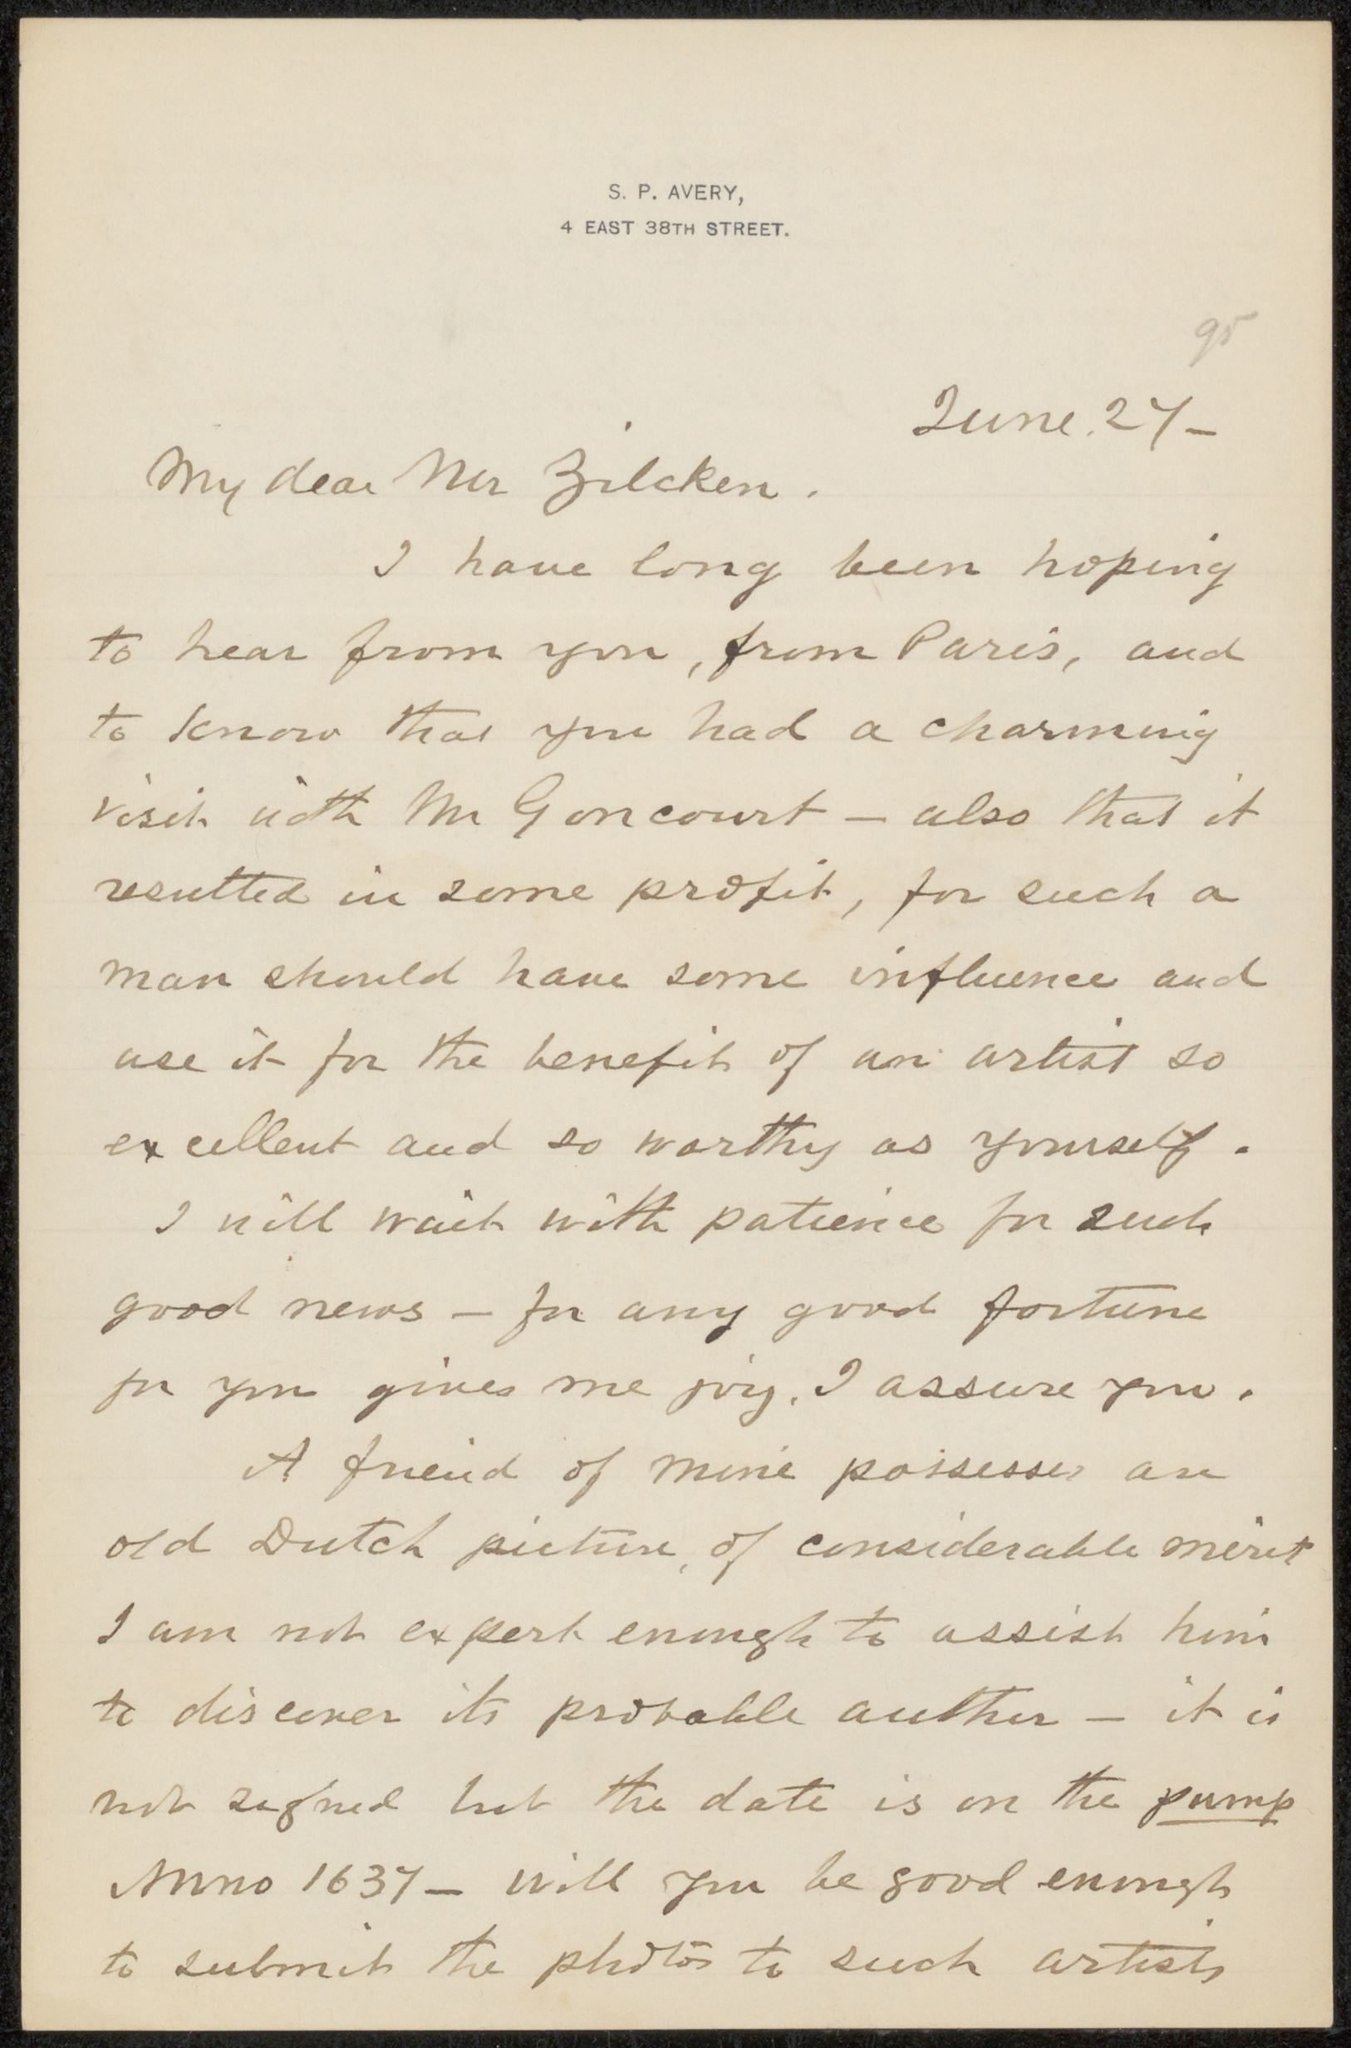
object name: letter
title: Brief aan Philip Zilcken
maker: samuel putnam avery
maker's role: verzamelaar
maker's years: 1822-1904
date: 1832-1904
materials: ink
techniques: pen, printing, writing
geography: new york city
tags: the hague, draughtsman, philip zilcken, the graphic arts, painting (including book-illumination, miniature-painting)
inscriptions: collector's mark: ‘RPK’